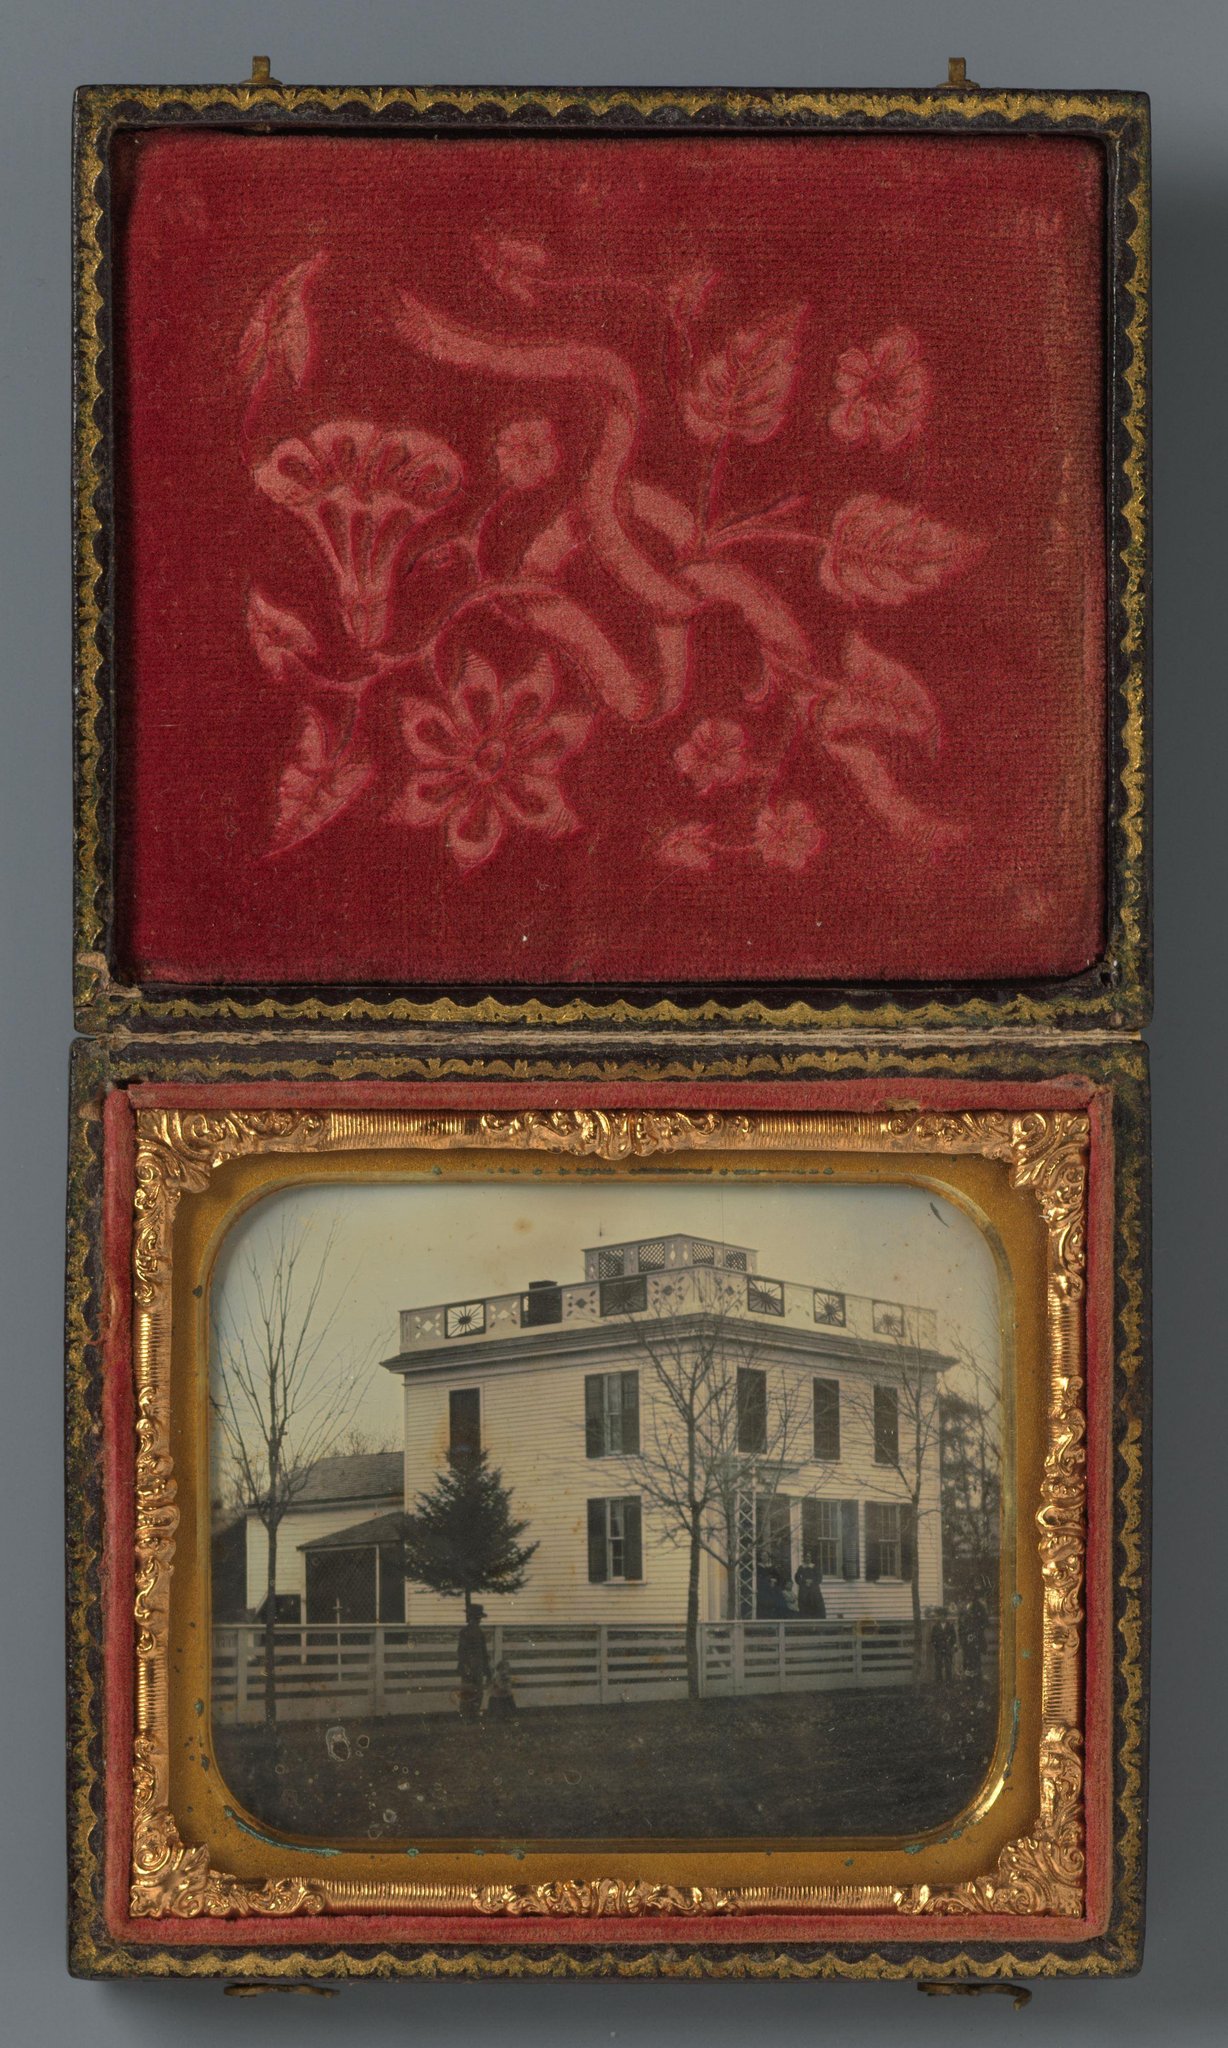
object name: photograph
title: Woonhuis met onbekende mensen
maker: Anonymous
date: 1852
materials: copper, glass, leather, velvet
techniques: daguerreotype, hand coloring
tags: historical persons, civic architecture; edifices; dwellings